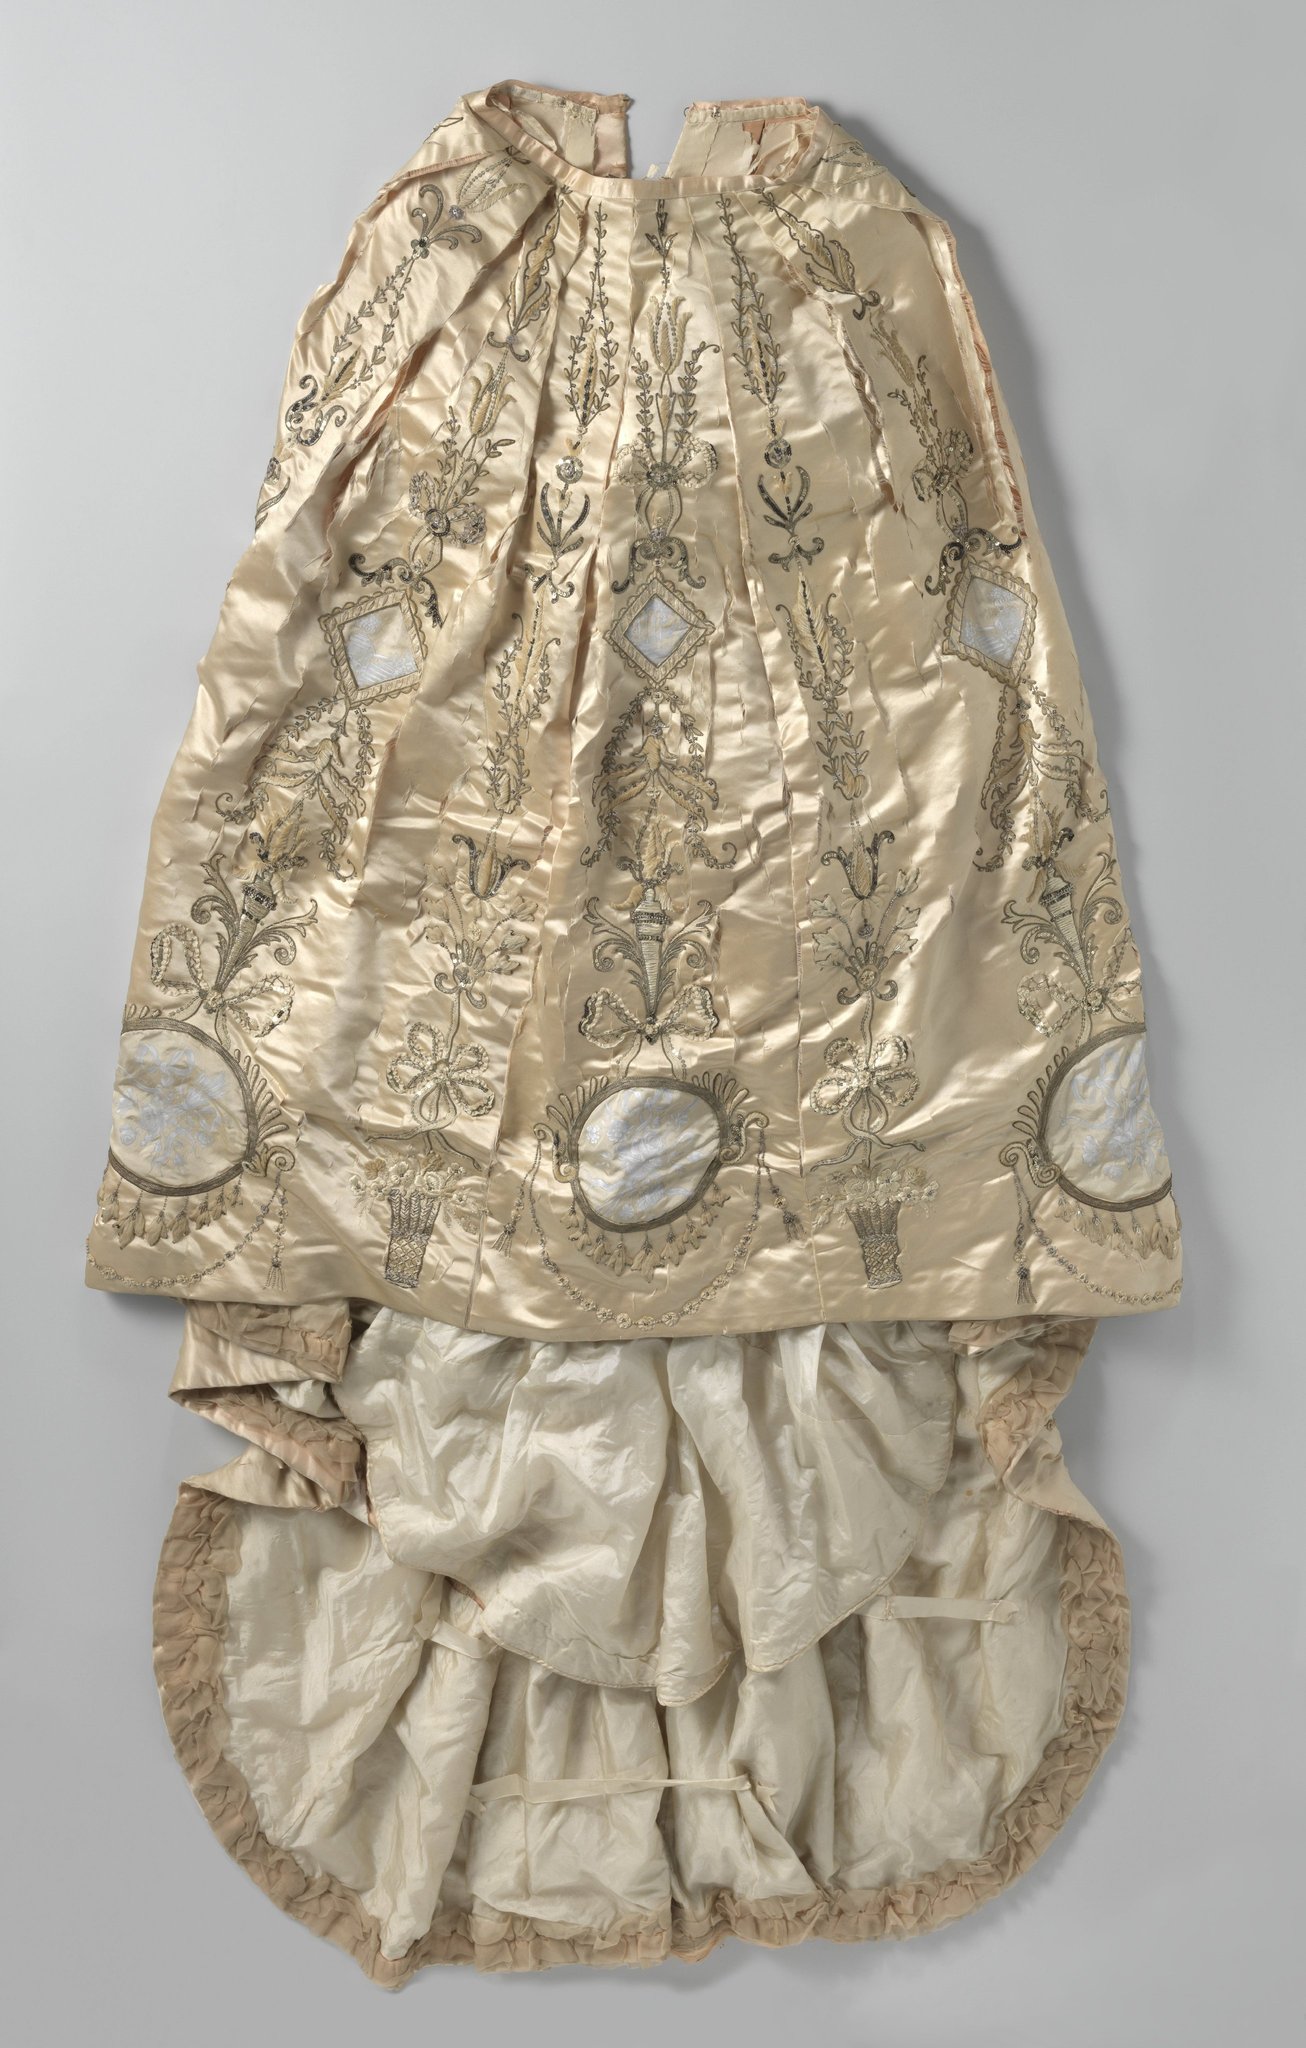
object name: skirt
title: Rok met sleep van zalmkleurige satijn, versierd met een rank- en kandelaberornament van zilverdraad en met medaillons met in grisaille geschilderde landschappen en boeketten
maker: jeanne paquin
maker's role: couturier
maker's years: 1869-1936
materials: oil, paint, silk, silver, thread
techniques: lace, weave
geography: paris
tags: amsterdam, the hague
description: Hofdame Thora van Loon-Egidius droeg deze japon bij het huwelijk van Wilhelmina, koningin der Nederlanden met Hendrik hertog van Mecklenburg-Schwerin op 7 februari 1901. Thora van Loon-Egidius schreef in haar dagboek: 'En nu eindelijk 7 februari de huwelijksdag. Mijn toilet was prachtig, een warm en vol tinten gekleurd roze, geheel geborduurd style Louis XVI met grijs en met kleine beschilderde paneeltjes, werkelijk een chef d'oeuvre. Daar Mevrouw van W. en ik zeer 'en evidence' zaten kwamen onze toiletten ook tot hun recht. Ik droeg om den hals het pas gekregen geschenk van mijnen man een pendant van diamanten met grooten zwaren paarl als milieu.' (R. Cleverens, Niet verder dan ons Huis..., Middelburg 1994 (I), p.230)